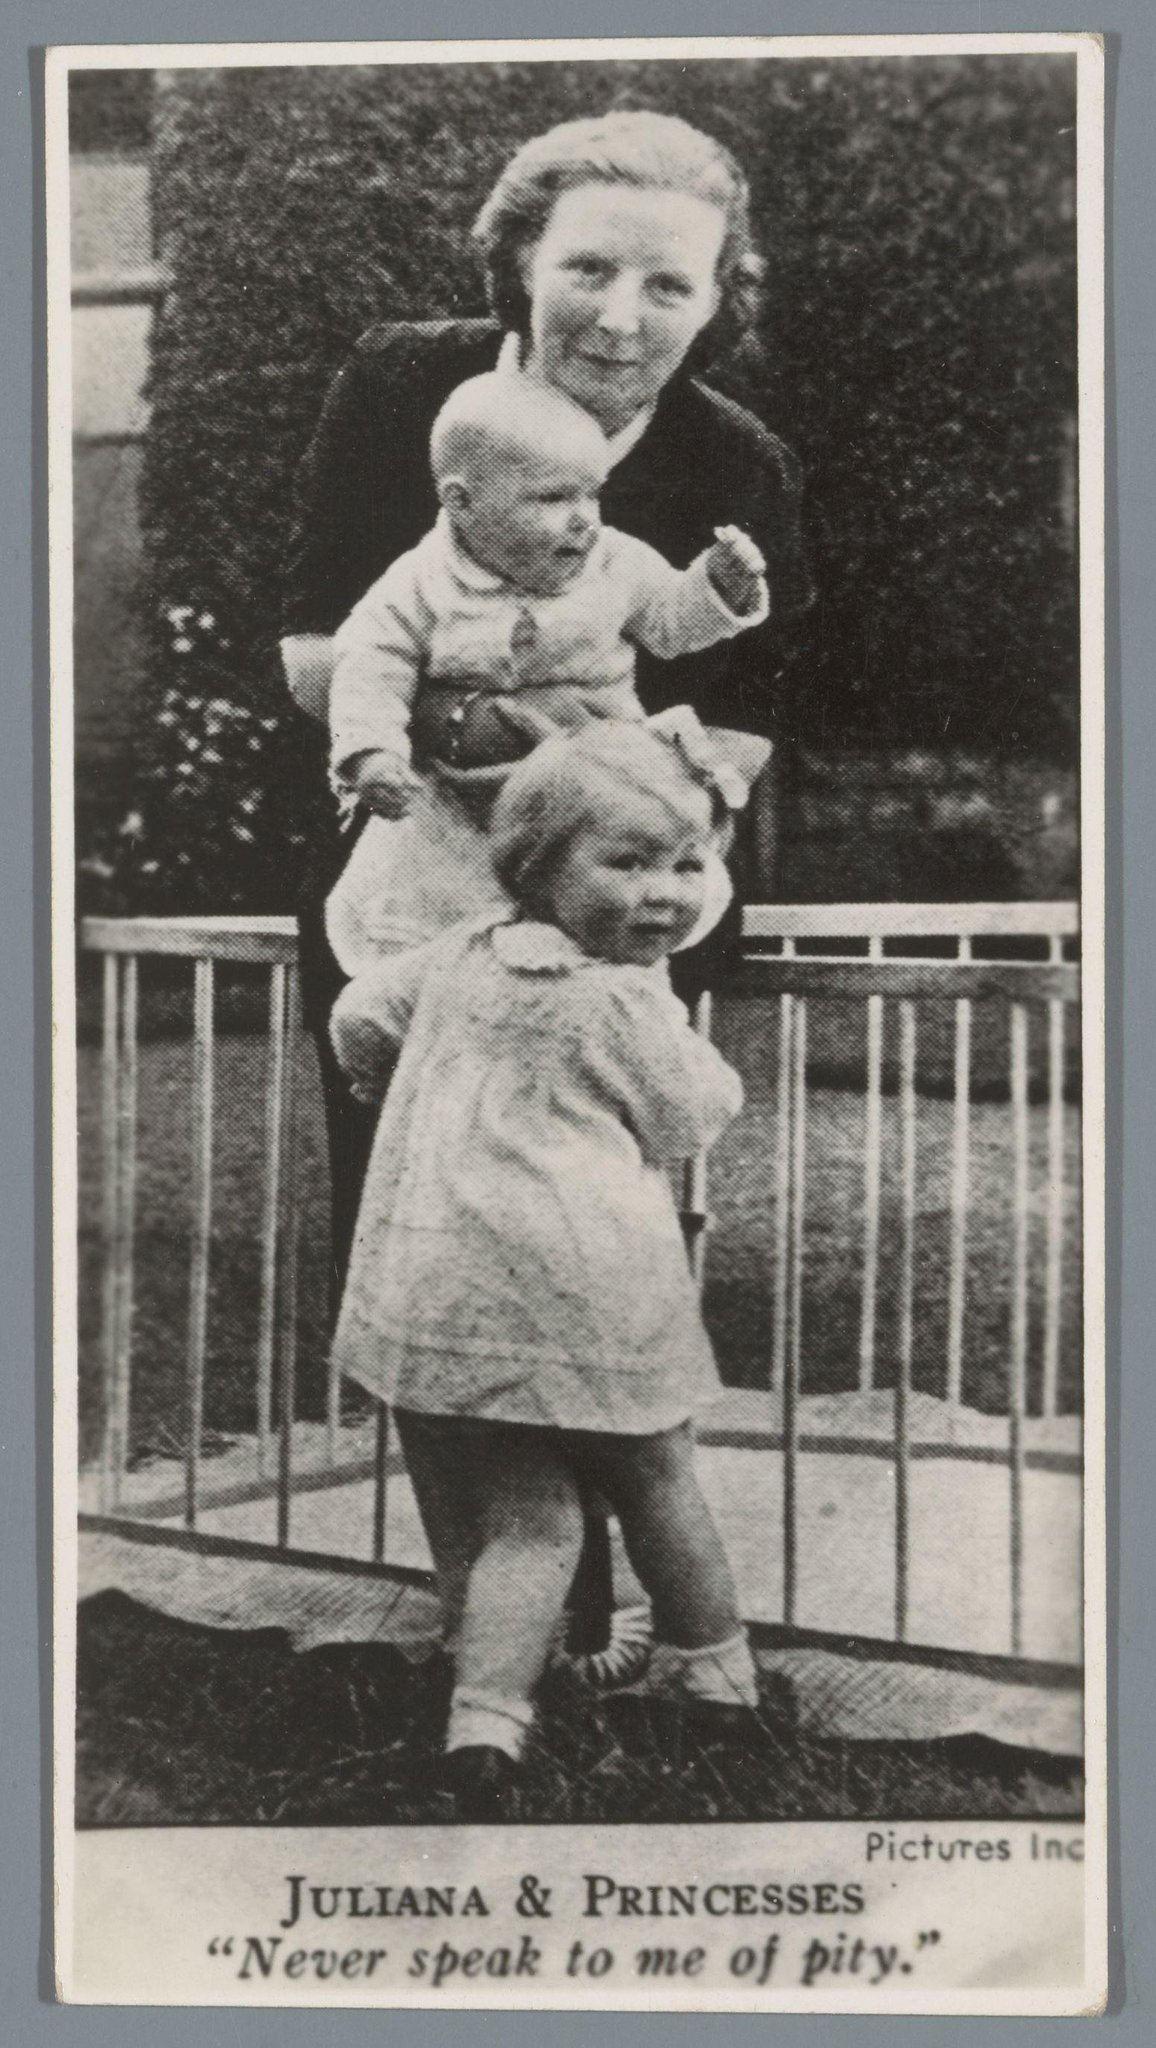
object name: photograph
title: Fotoreproductie van een nieuwsfoto van prinses Juliana, prinses Beatrix en prinses Irene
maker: Anonymous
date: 1940-1943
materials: photographic support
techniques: gelatin silver print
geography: ottawa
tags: beatrix (koningin der nederlanden), juliana of the netherlands, family of the sovereign